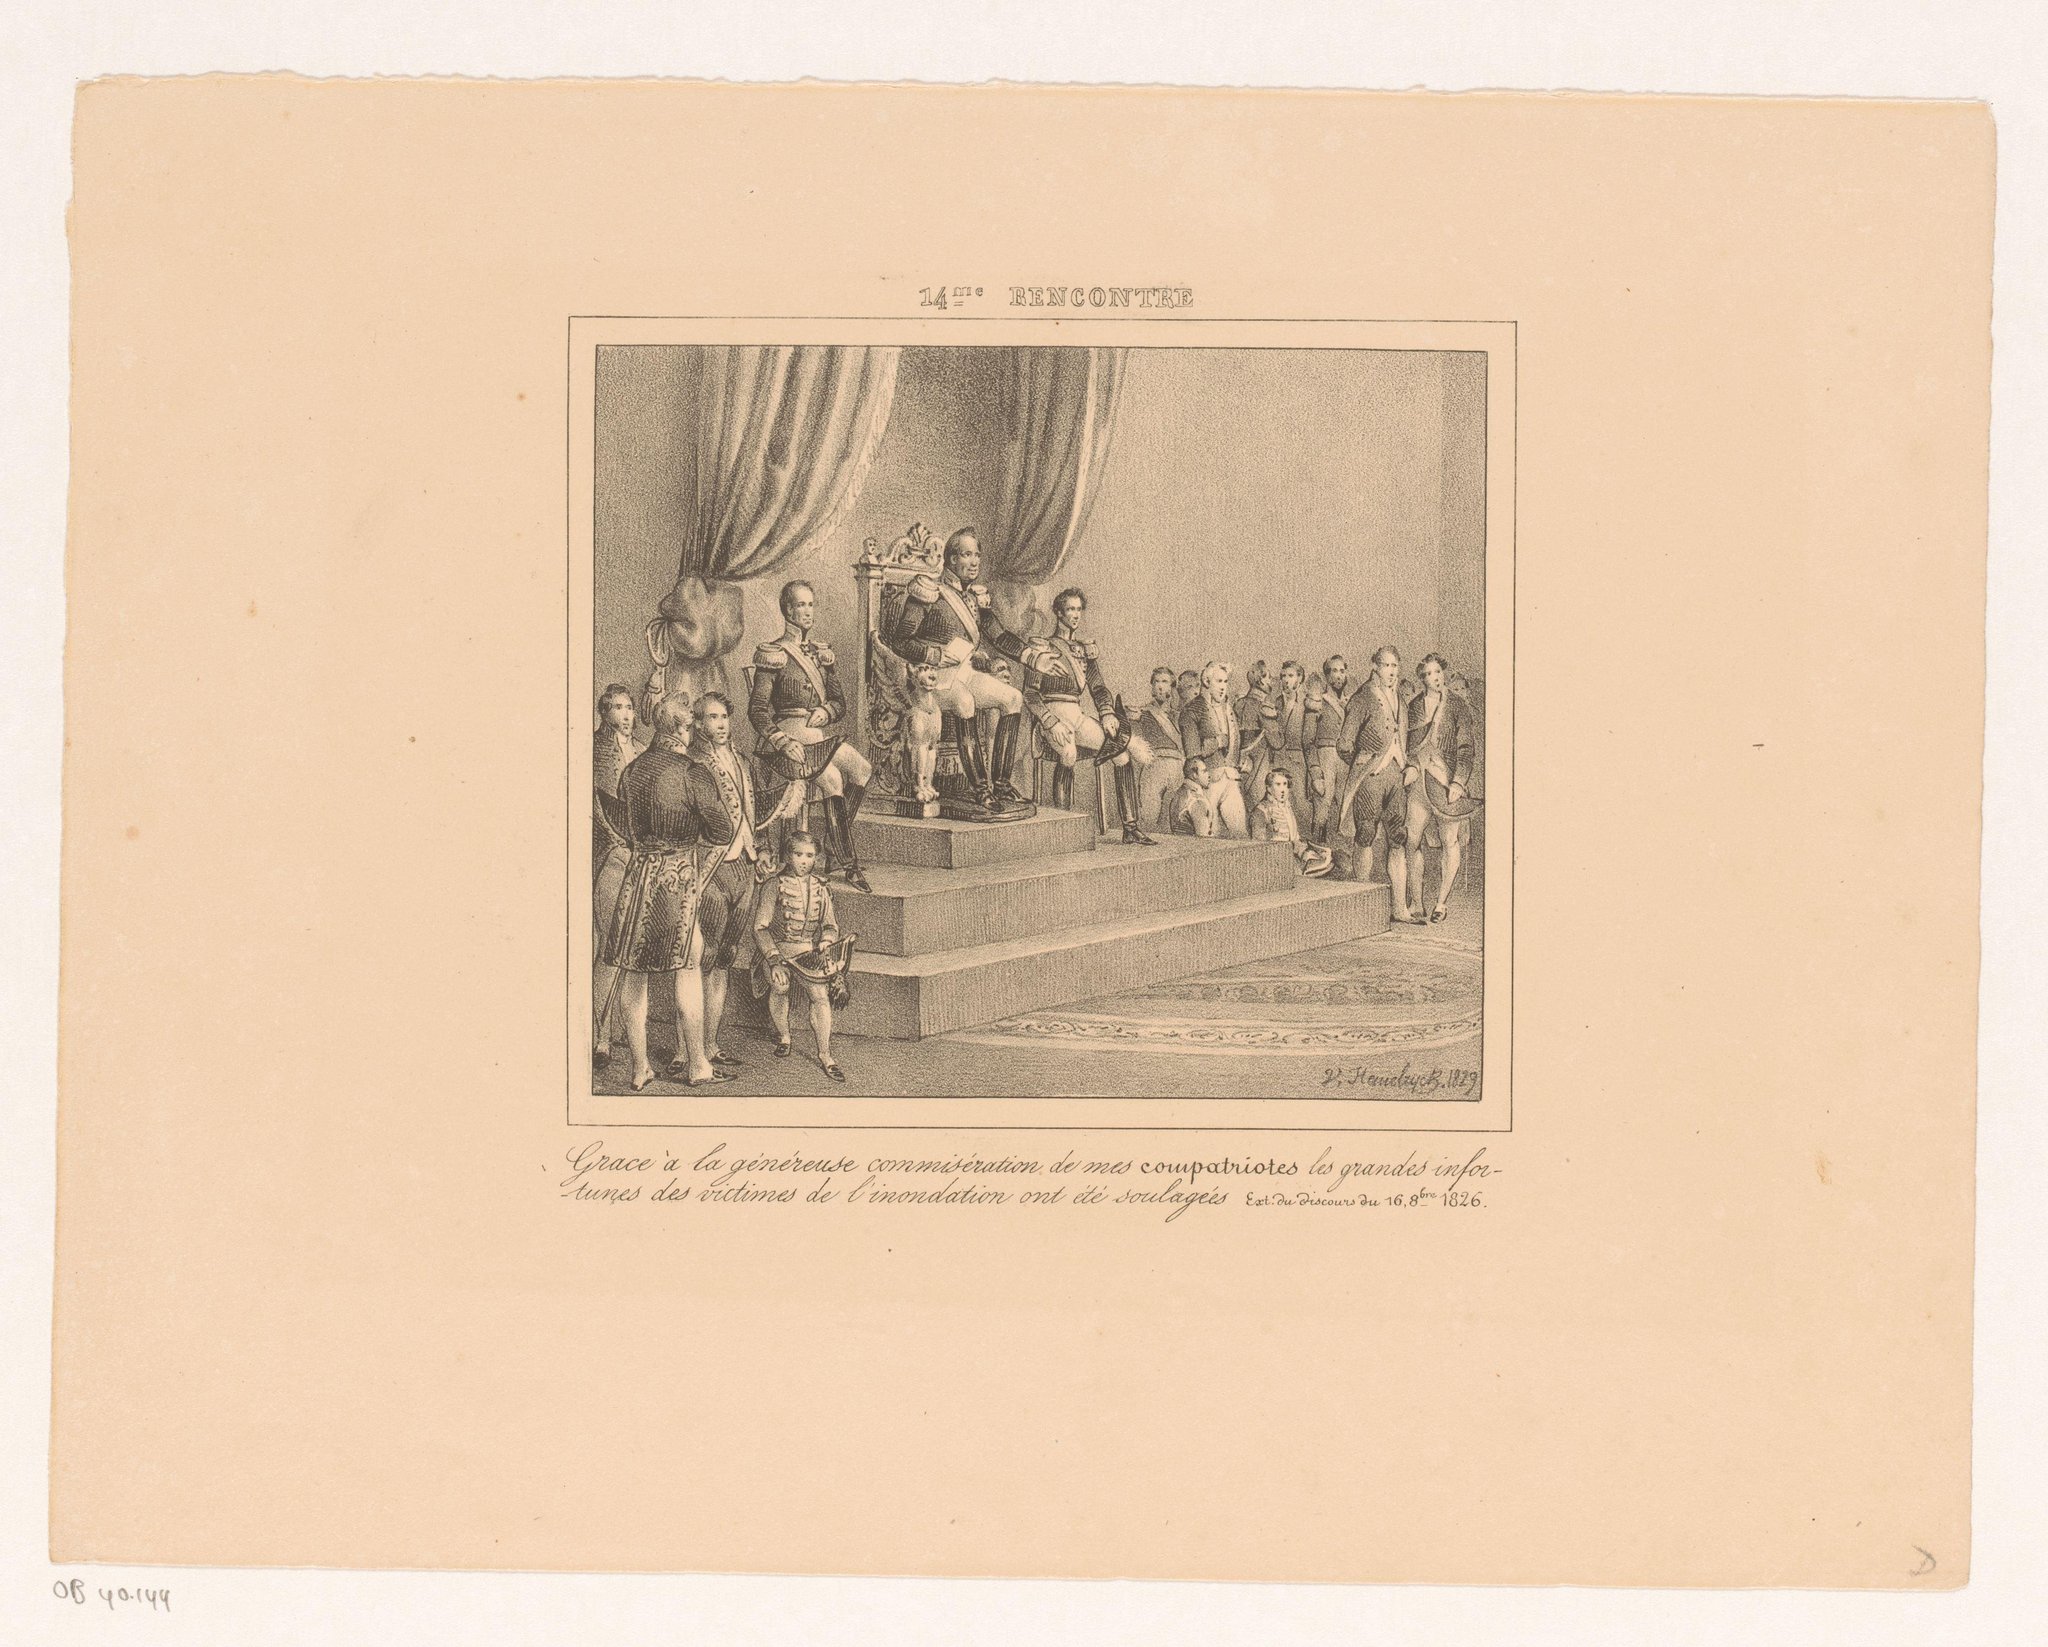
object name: print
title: Les rencontres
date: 1829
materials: paper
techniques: lithograph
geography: brussels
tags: the hague, berlin, william i of the netherlands, william ii of the netherlands, frederik (prins der nederlanden), popular representation ~ government, official acts of rulers, e.g. royal acts (ruler giving audience, granting mercy, etc.; ruler and his subjects)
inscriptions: collector's mark: Lugt 2228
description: Koning Willem I dankt bij opening van de Kamers op 16 oktober 1826 zijn landgenoten voor de hulp verleend aan de slachtoffers van de watersnood. De koning zit op zijn troon. Aan weerszijden van hem zitten zijn zoons, de kroonprins en prins Frederik. Met tweeregelig onderschrift.